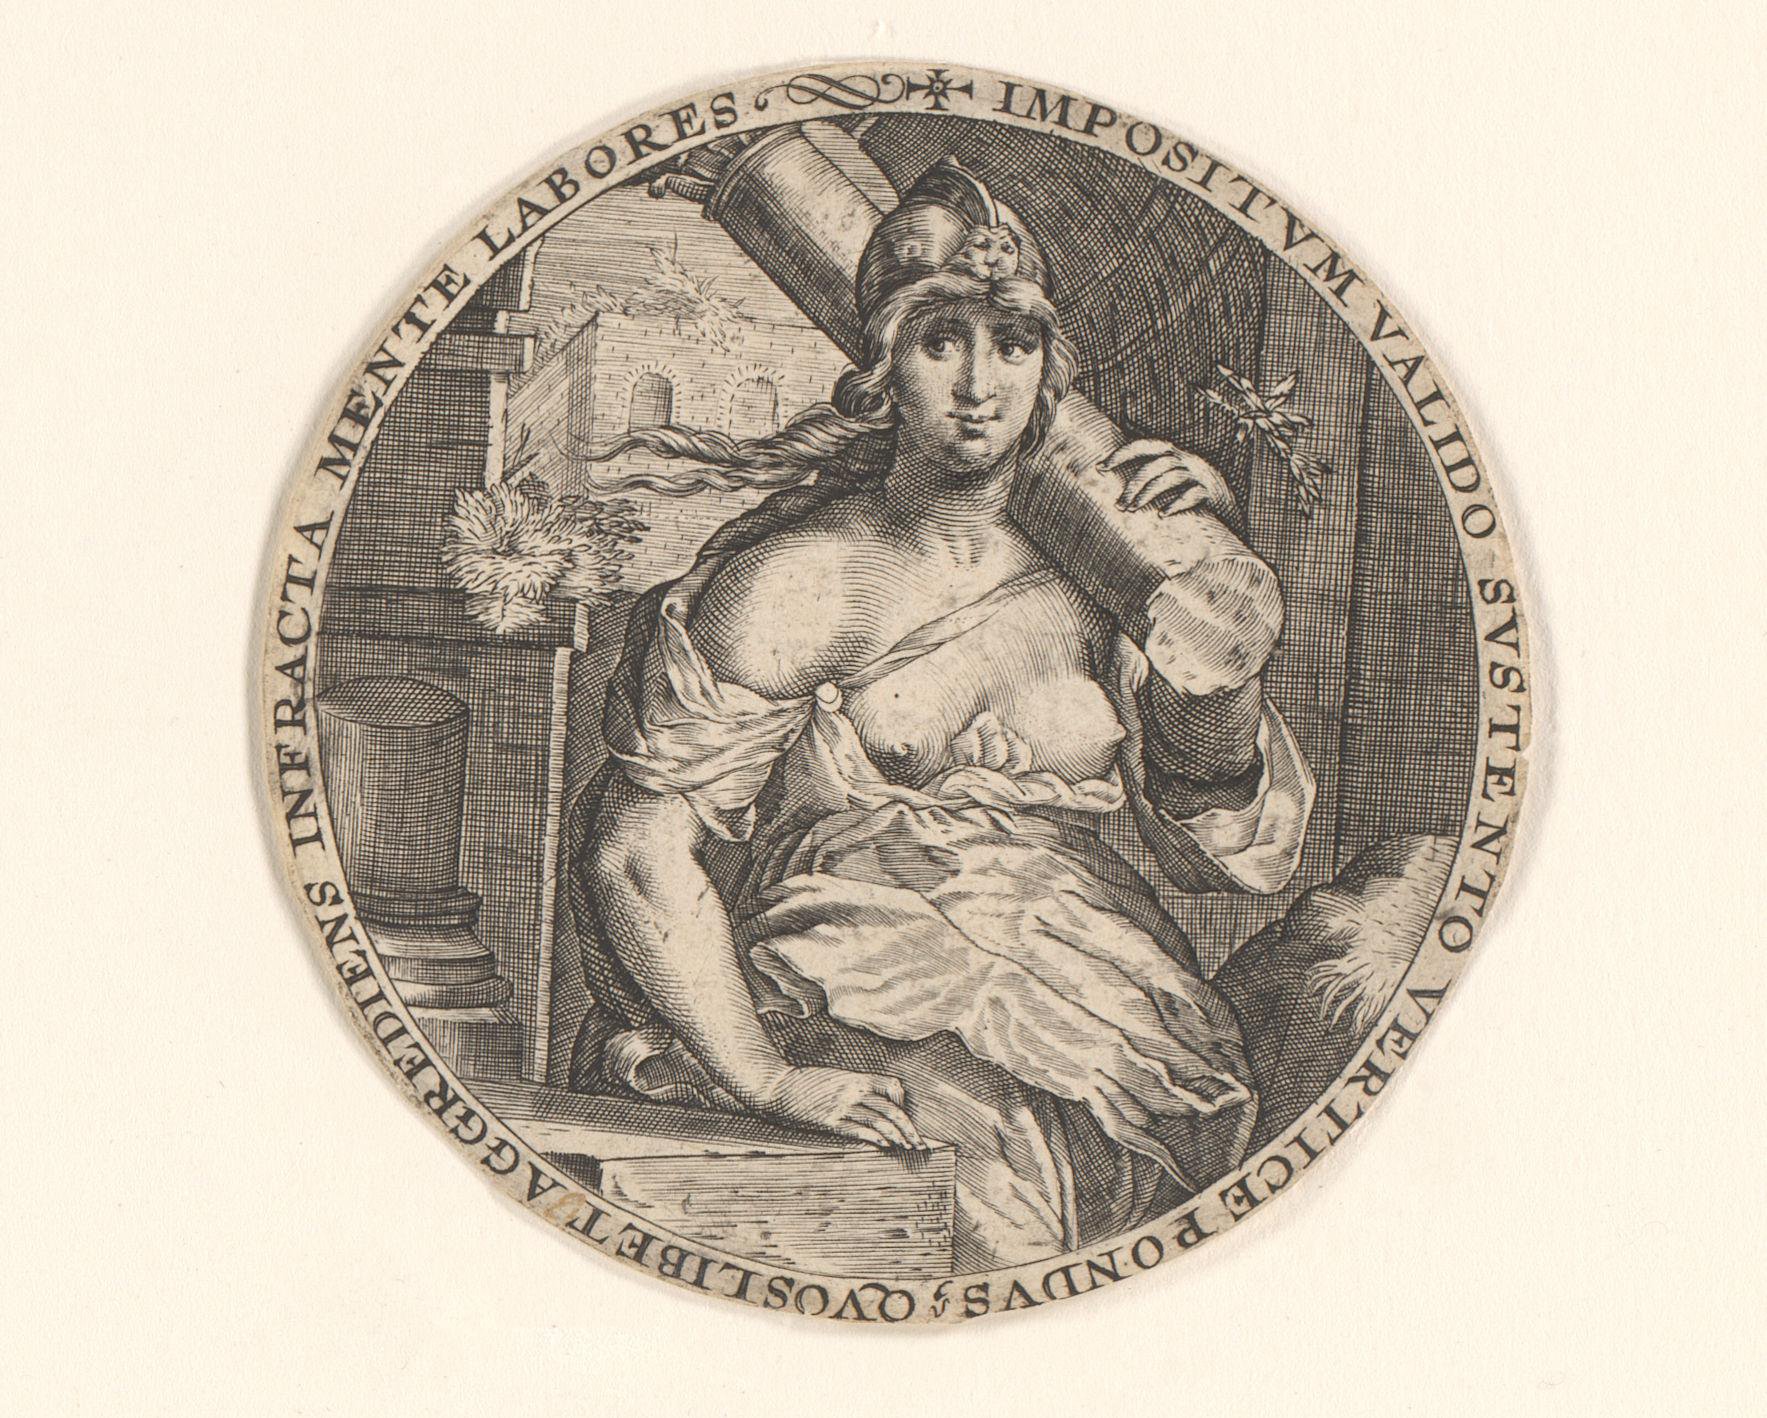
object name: print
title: Virtutu Theologicaru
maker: crispijn van de passe (i)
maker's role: draughtsman, print maker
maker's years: 1564-1637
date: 1600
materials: paper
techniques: engraving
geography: cologne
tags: fortitude, 'fortitudo' ~ one of the four cardinal virtues